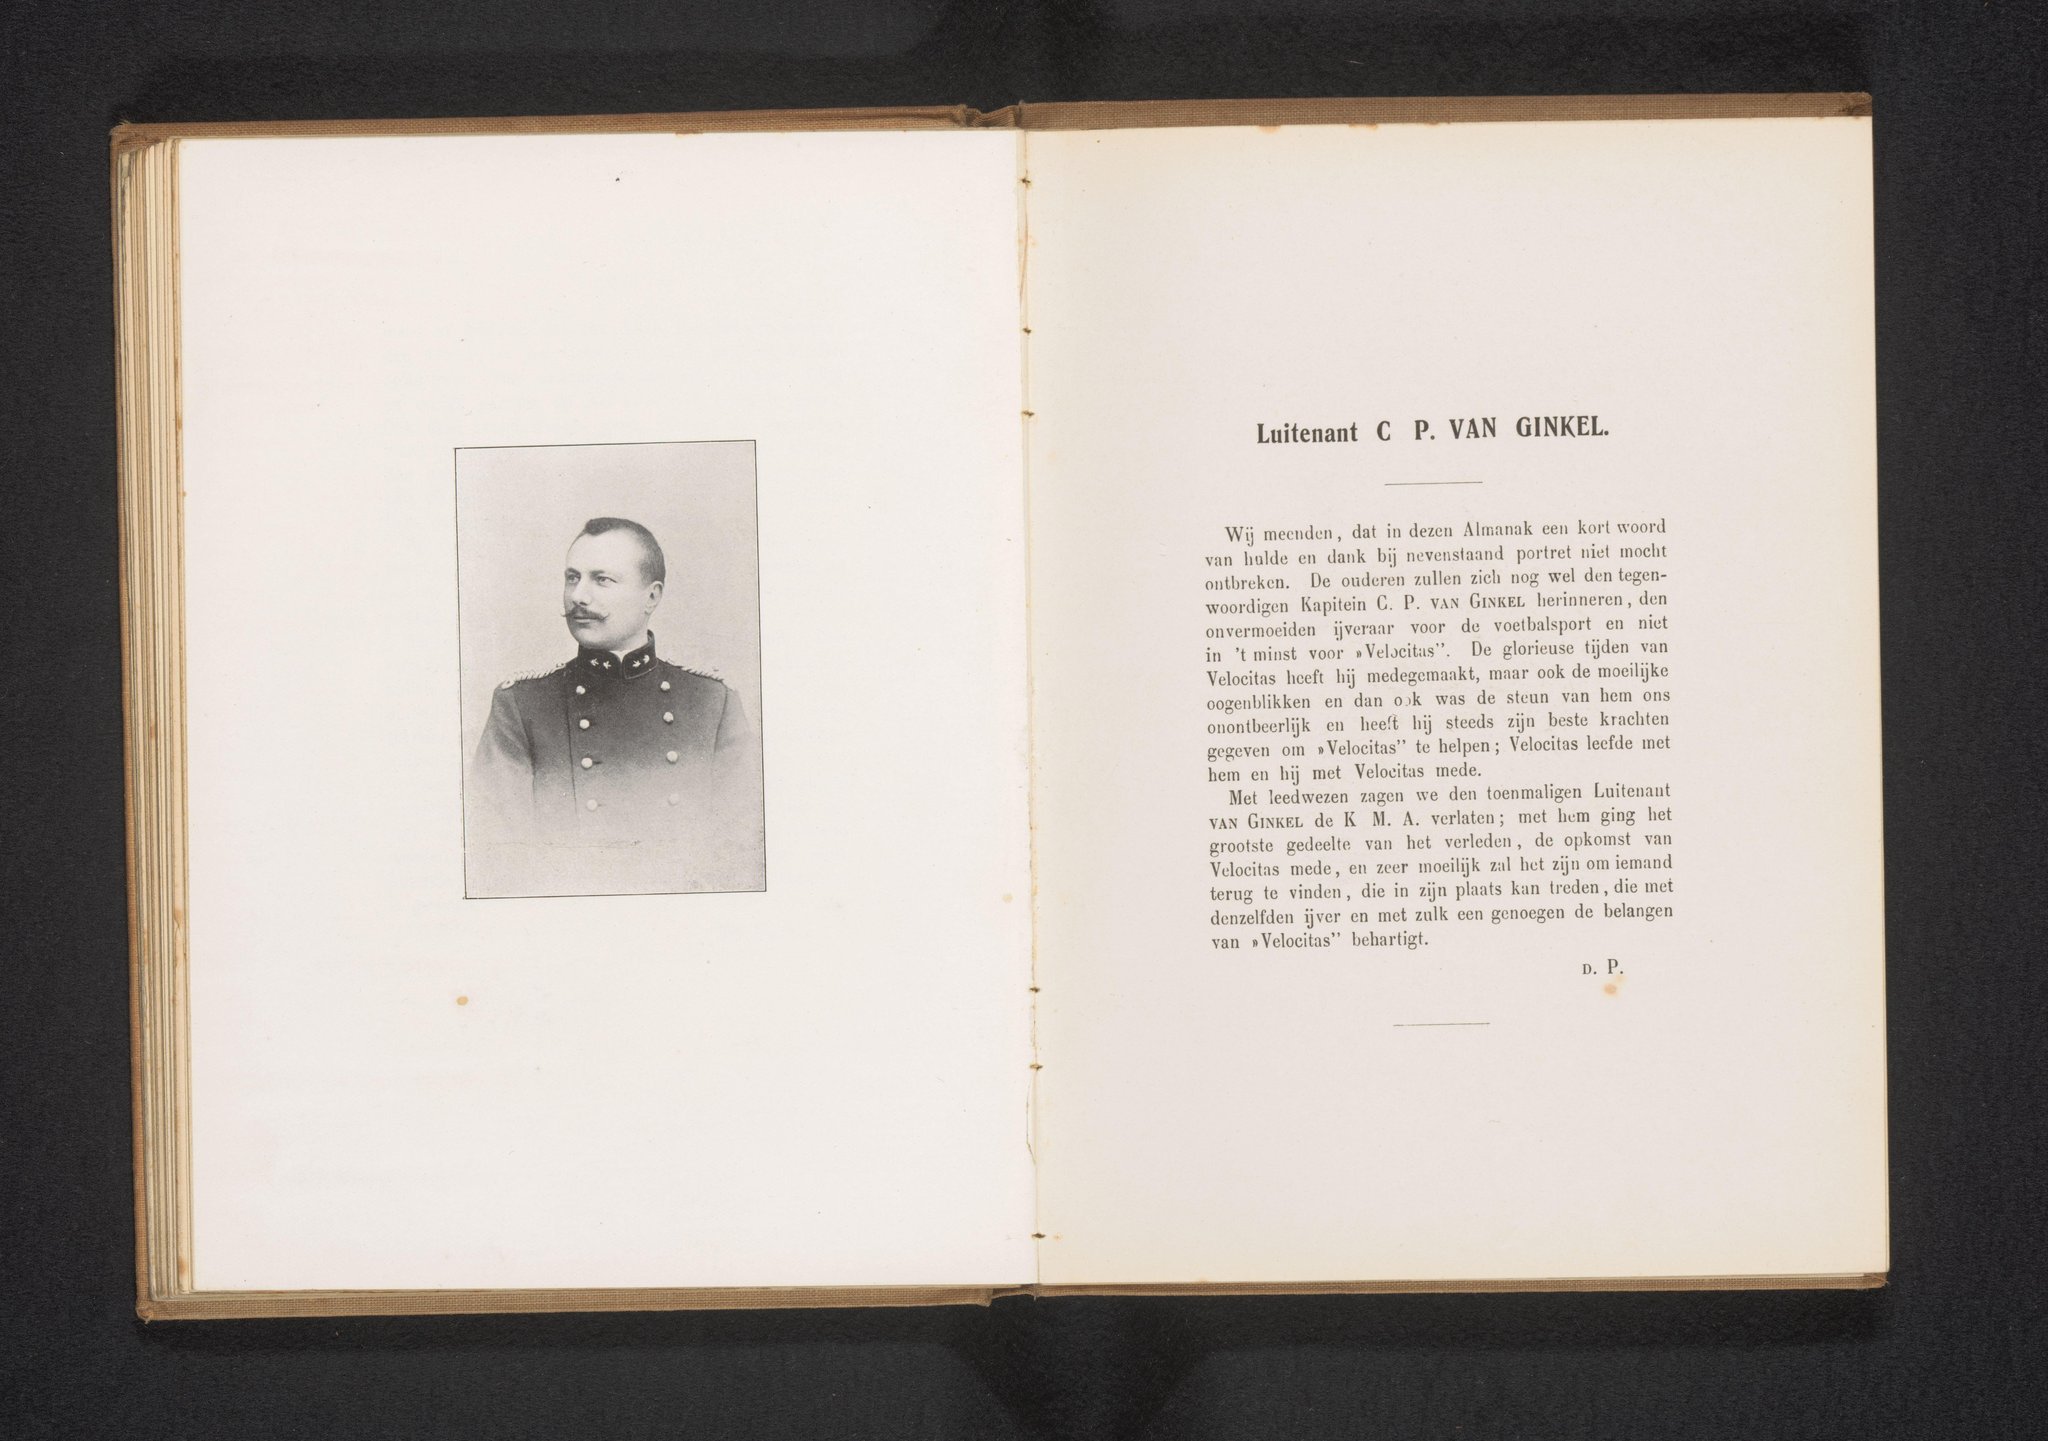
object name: photomechanical print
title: Portret van een onbekende officier van de Koninklijke Militaire Academie in Breda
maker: Anonymous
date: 1904-1909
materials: paper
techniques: autotype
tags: officer, historical persons not known by name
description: Prent op tweede ongenummerde pagina na pagina CXLII.